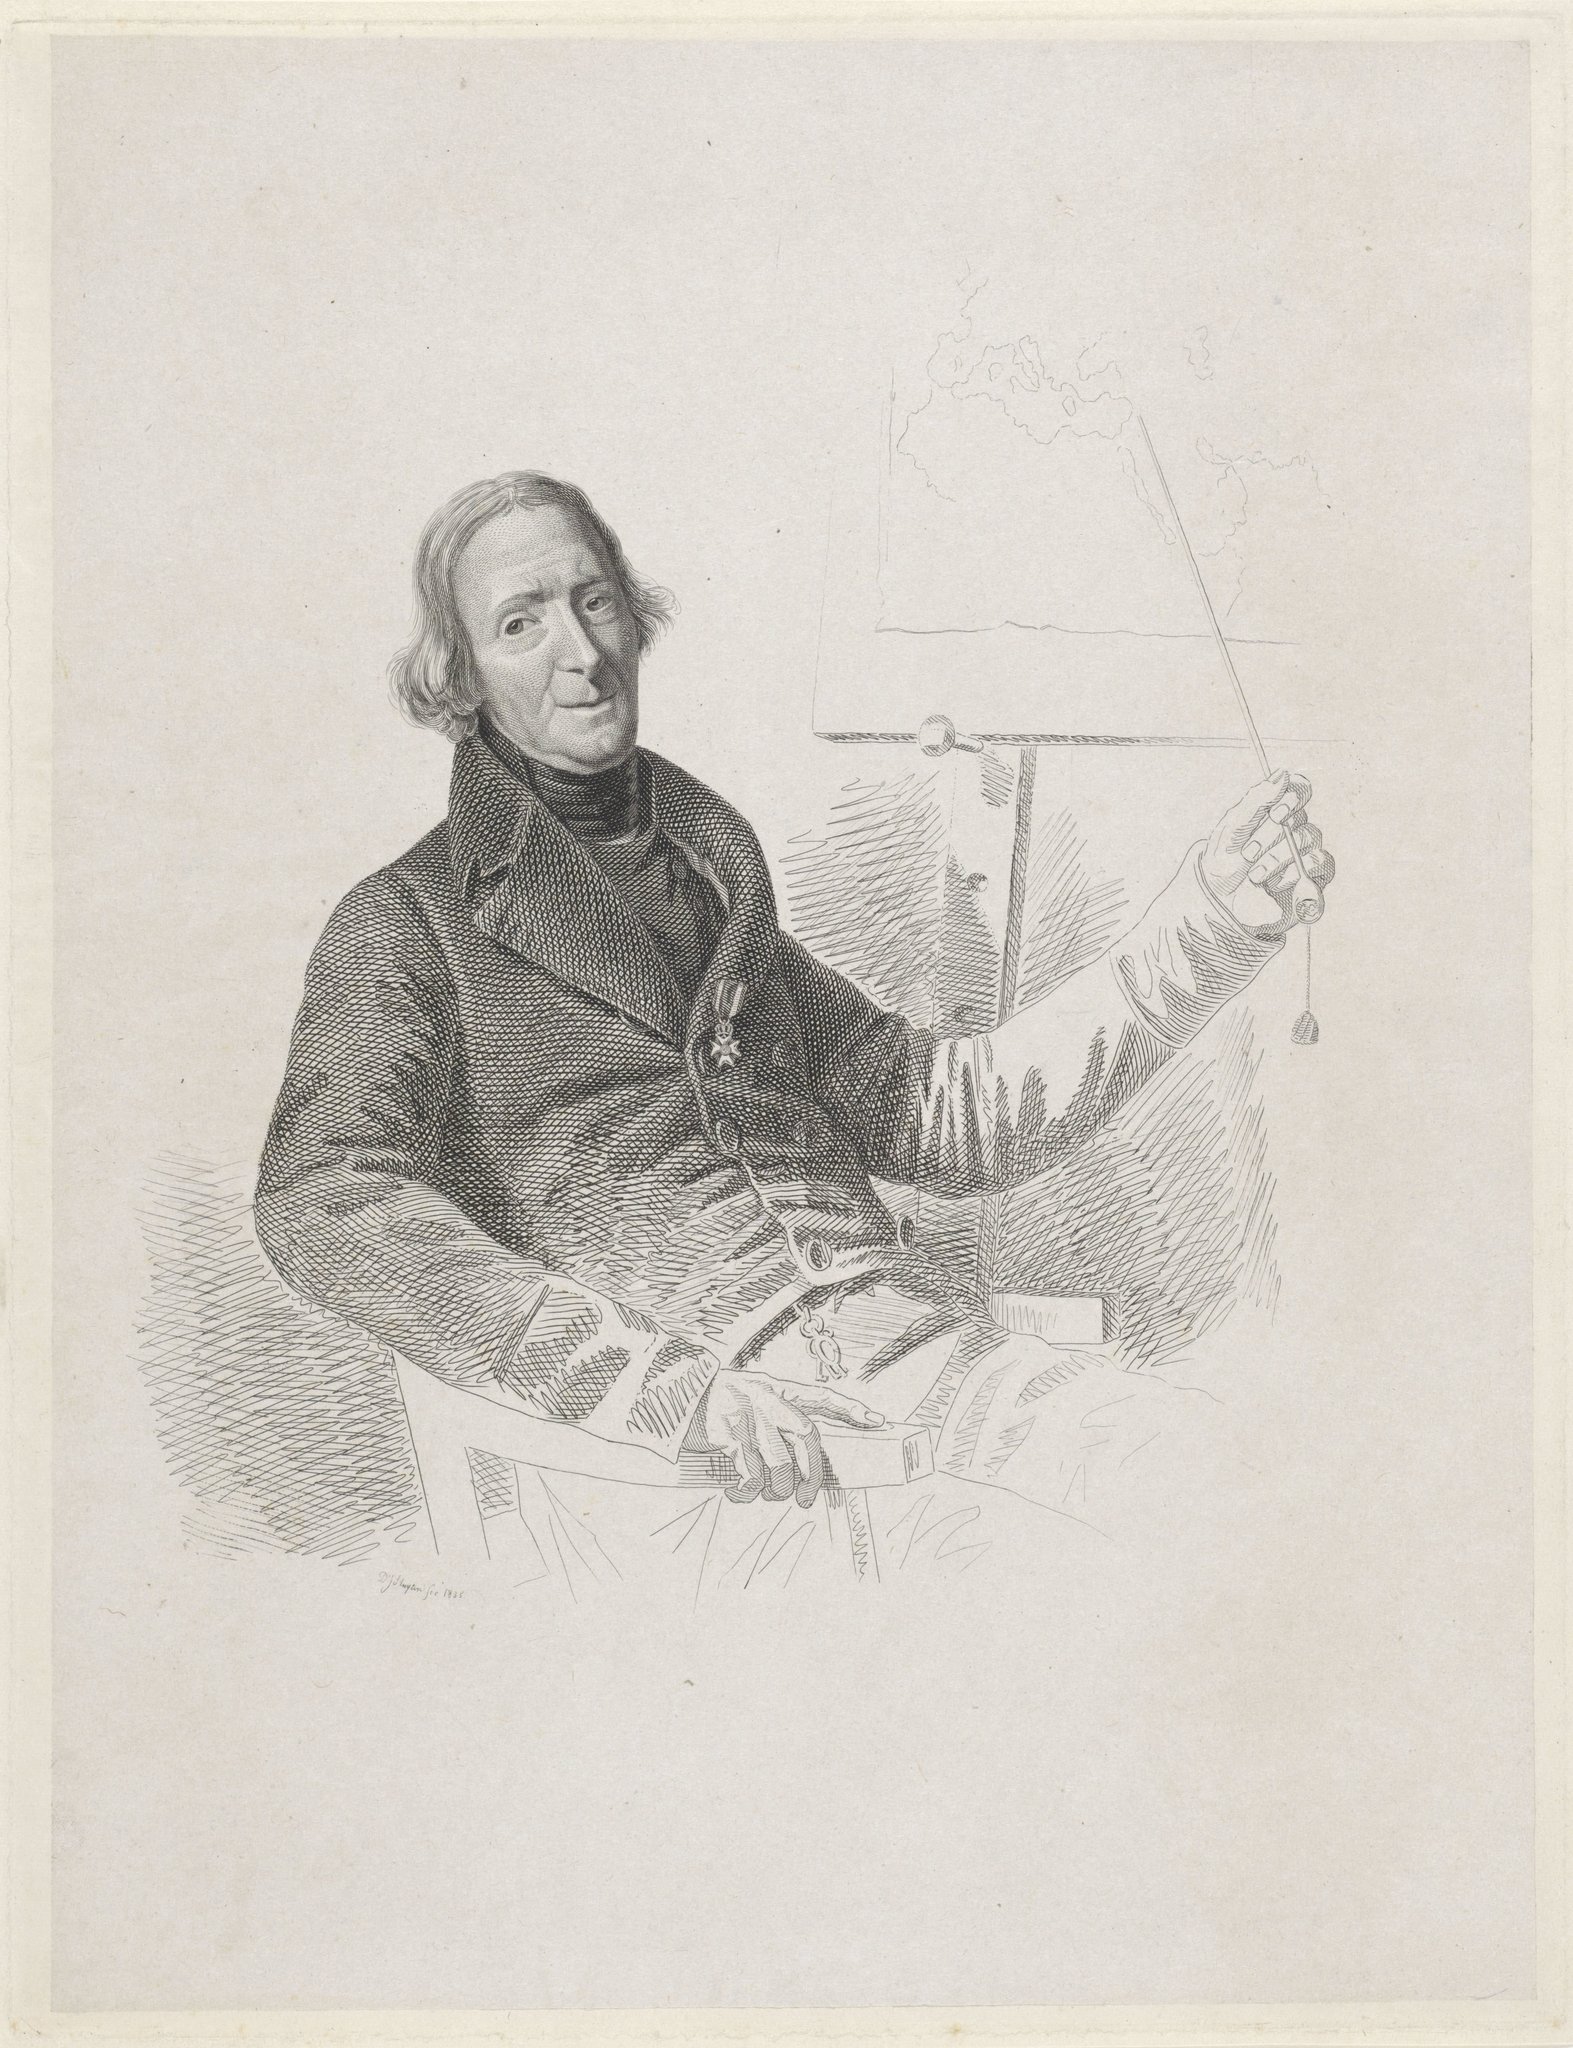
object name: print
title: Portret van Johannes ter Pelkwijk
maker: dirk jurriaan sluyter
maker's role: draughtsman, print maker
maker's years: 1811-1886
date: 1835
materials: paper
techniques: engraving, etching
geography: amsterdam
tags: pointer ~ reading, maps, atlases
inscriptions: collector's mark: Lugt 2228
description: Portret van de staatsman, historicus en schrijver van schoolboeken Johannes ter Pelkwijk. Hij zit op een stoel en wijst met een aanwijsstok een geografische kaart aan, die op een ezel achter hem staat.